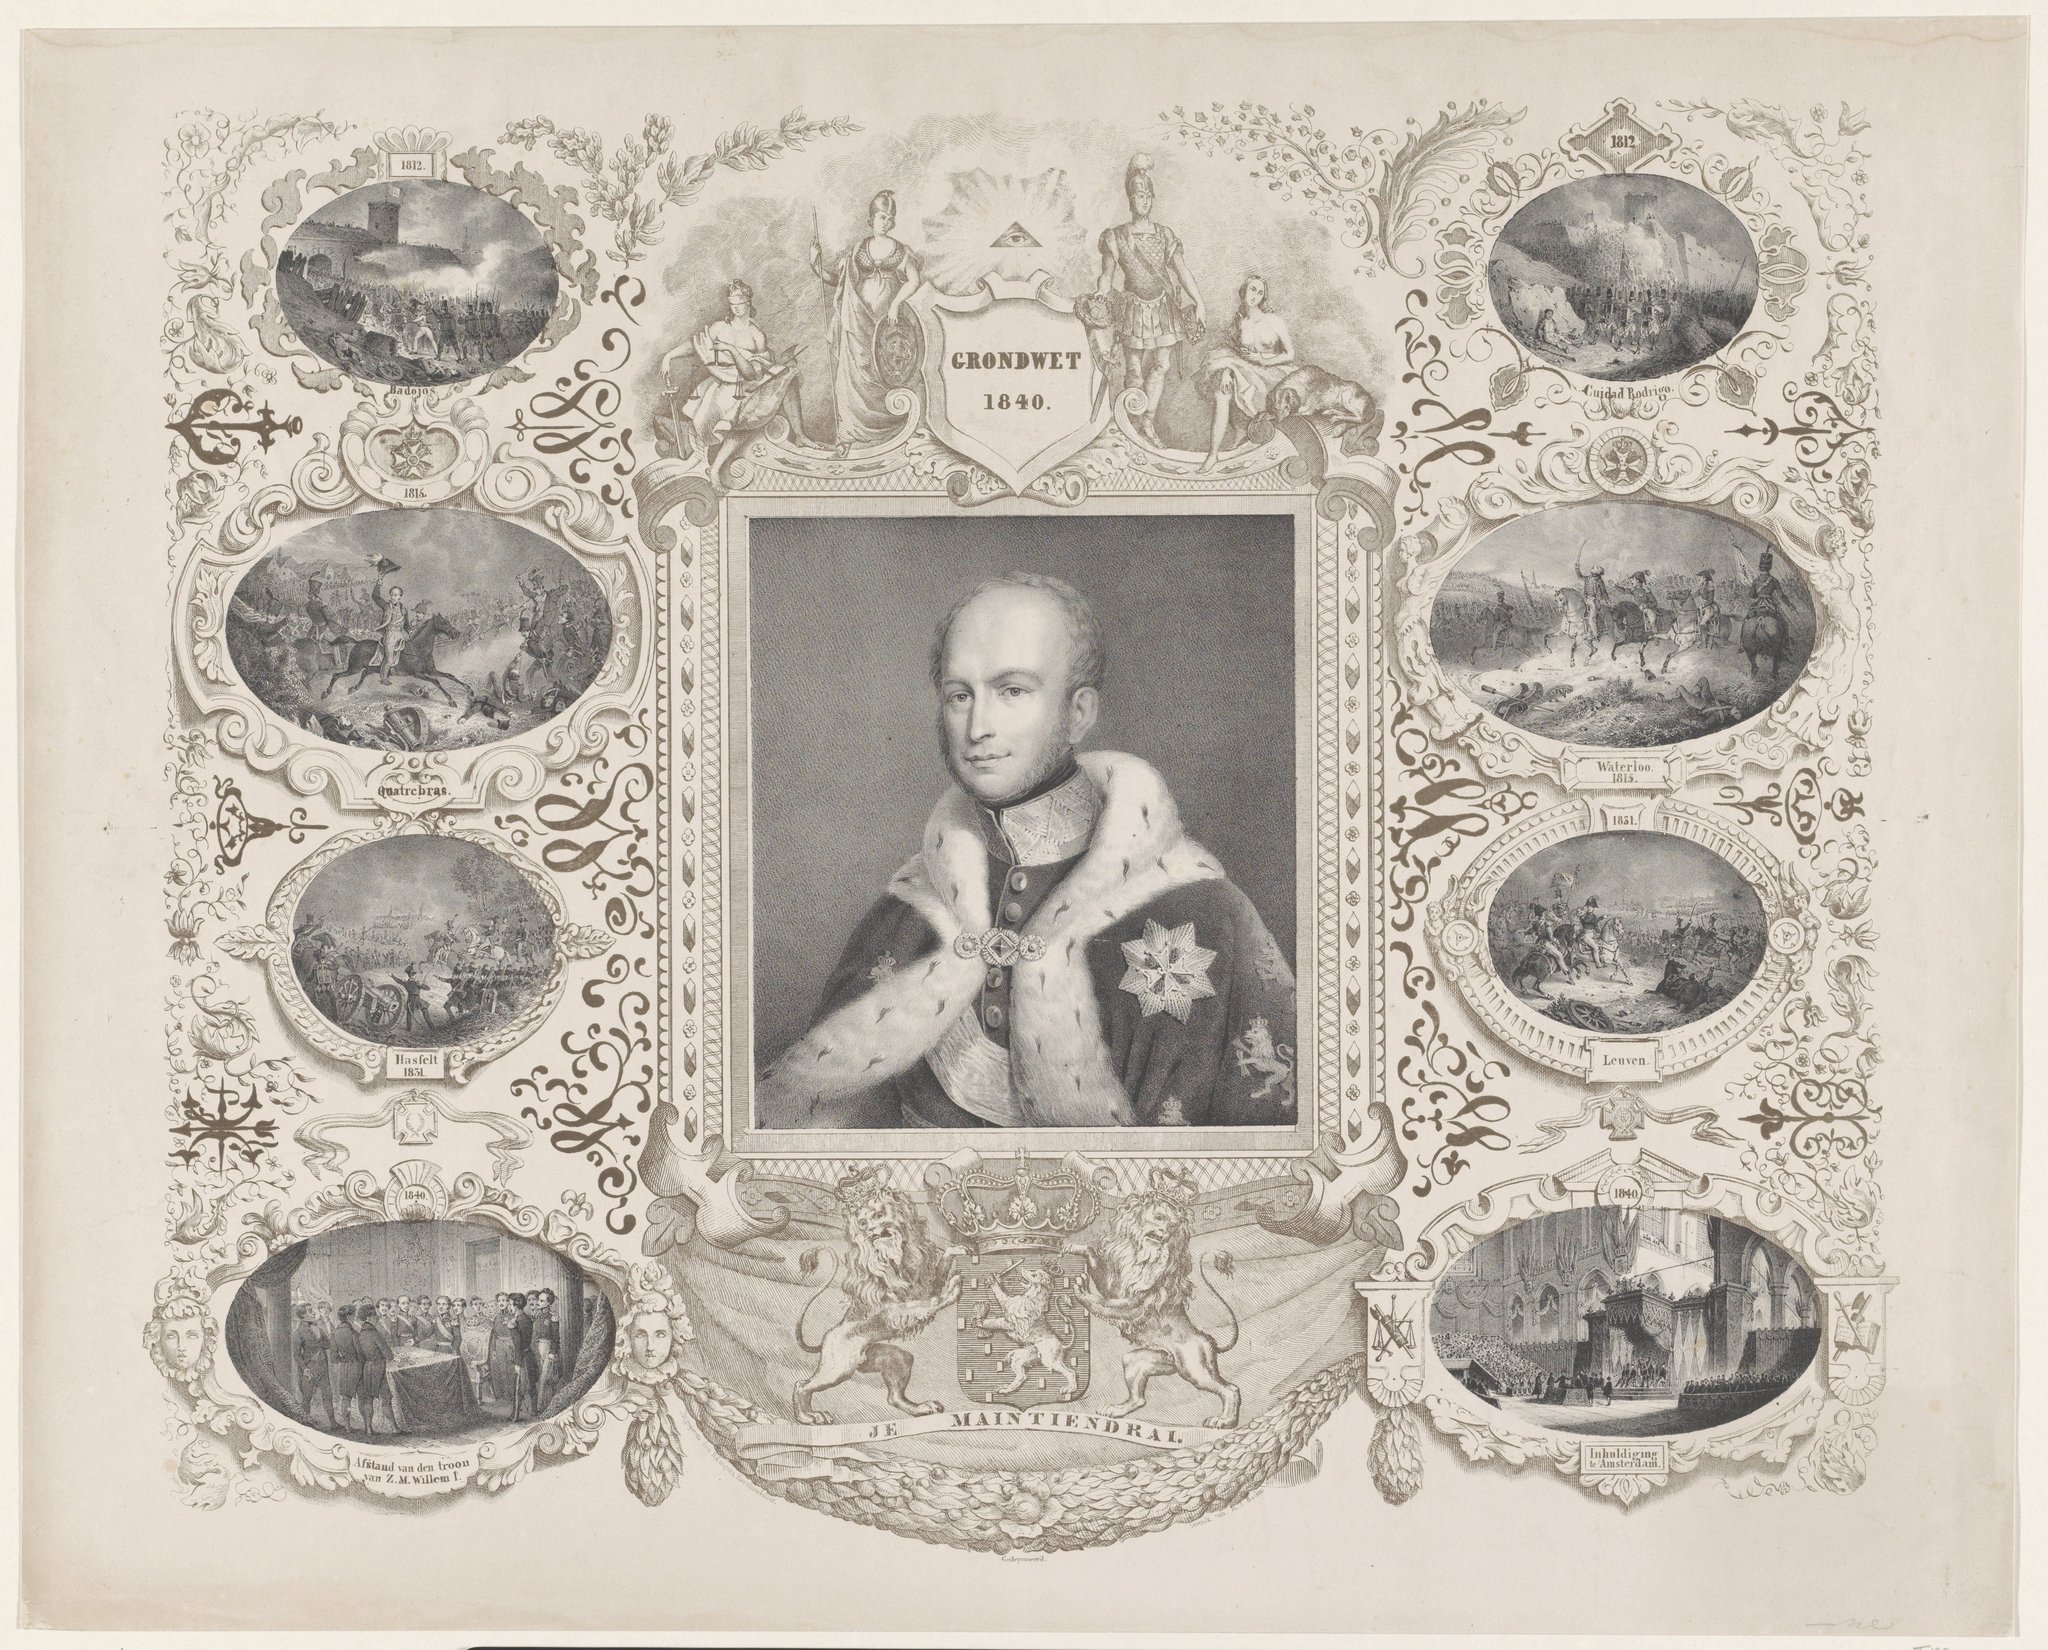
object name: print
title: Allegorie op de troonsbestijging van koning Willem II, 1840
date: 1840-1841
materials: paper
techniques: lithograph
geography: netherlands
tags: the hague, berlin, william i of the netherlands, william ii of the netherlands, new ruler taking the oath, battle (+ land forces), voluntary abdication (of a ruler)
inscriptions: : ‘Gedeponeerd’, collector's mark: Lugt 2228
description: Allegorie op de troonsbestijging van koning Willem II, 1840. Centraal een portret van de koning in de koninklijke mantel met het grootkruis van de Militaire Willemsorde. Links en rechts binnen een ornamentele omlijsting acht voorstellingen van belangrijke gebeurtenissen uit het leven van Willem II uit de jaren 1812-1840. Bovenaan een allegorische voorstelling met een schild met de grondwet van 1840, onderaan het wapen van de koning. Zie ook de pendant.